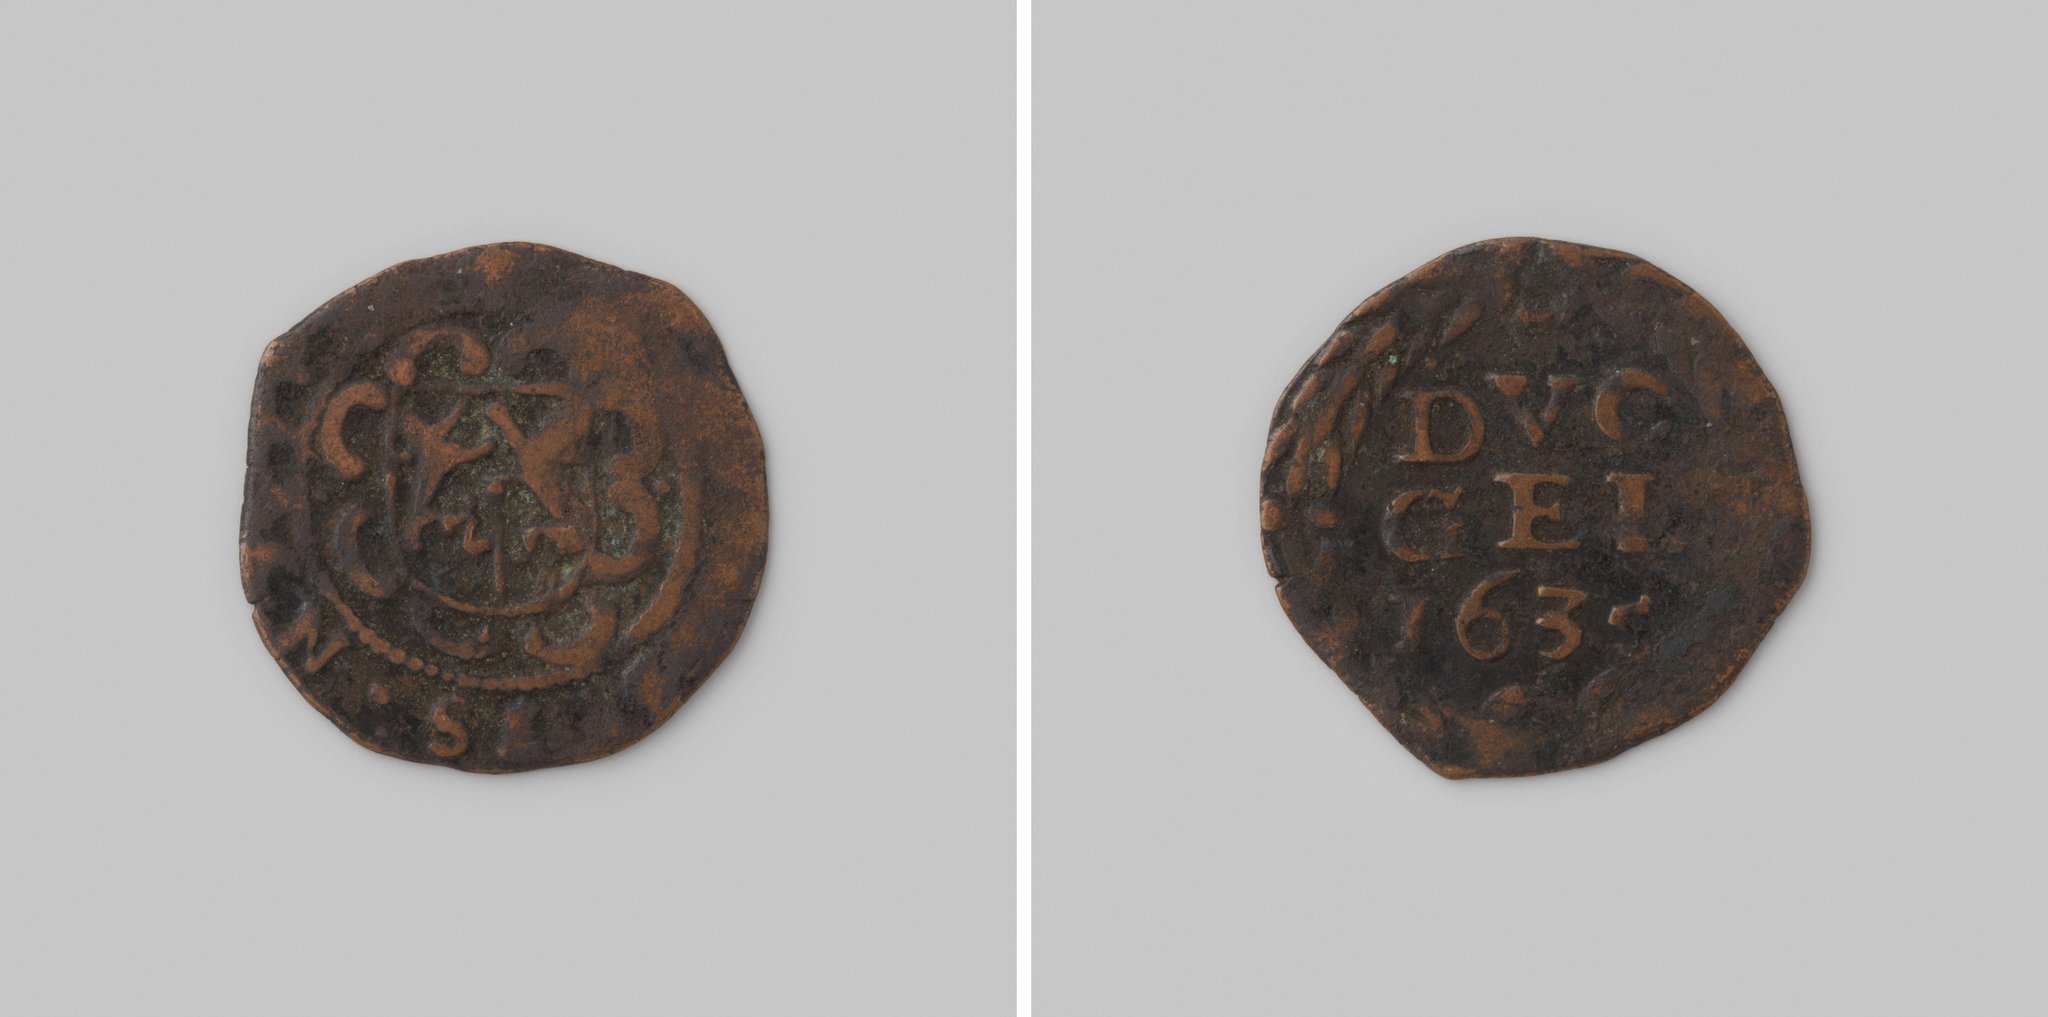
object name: coin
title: Gelderland, duit, 1635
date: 1635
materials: copper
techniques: striking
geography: harderwijk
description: Koperen munt. Voorzijde: binnen lauwerkrans in twee regels DVC/GEL, daaronder jaartal. Keerzijde: binnen versierde veelpas Gelders wapenschild.